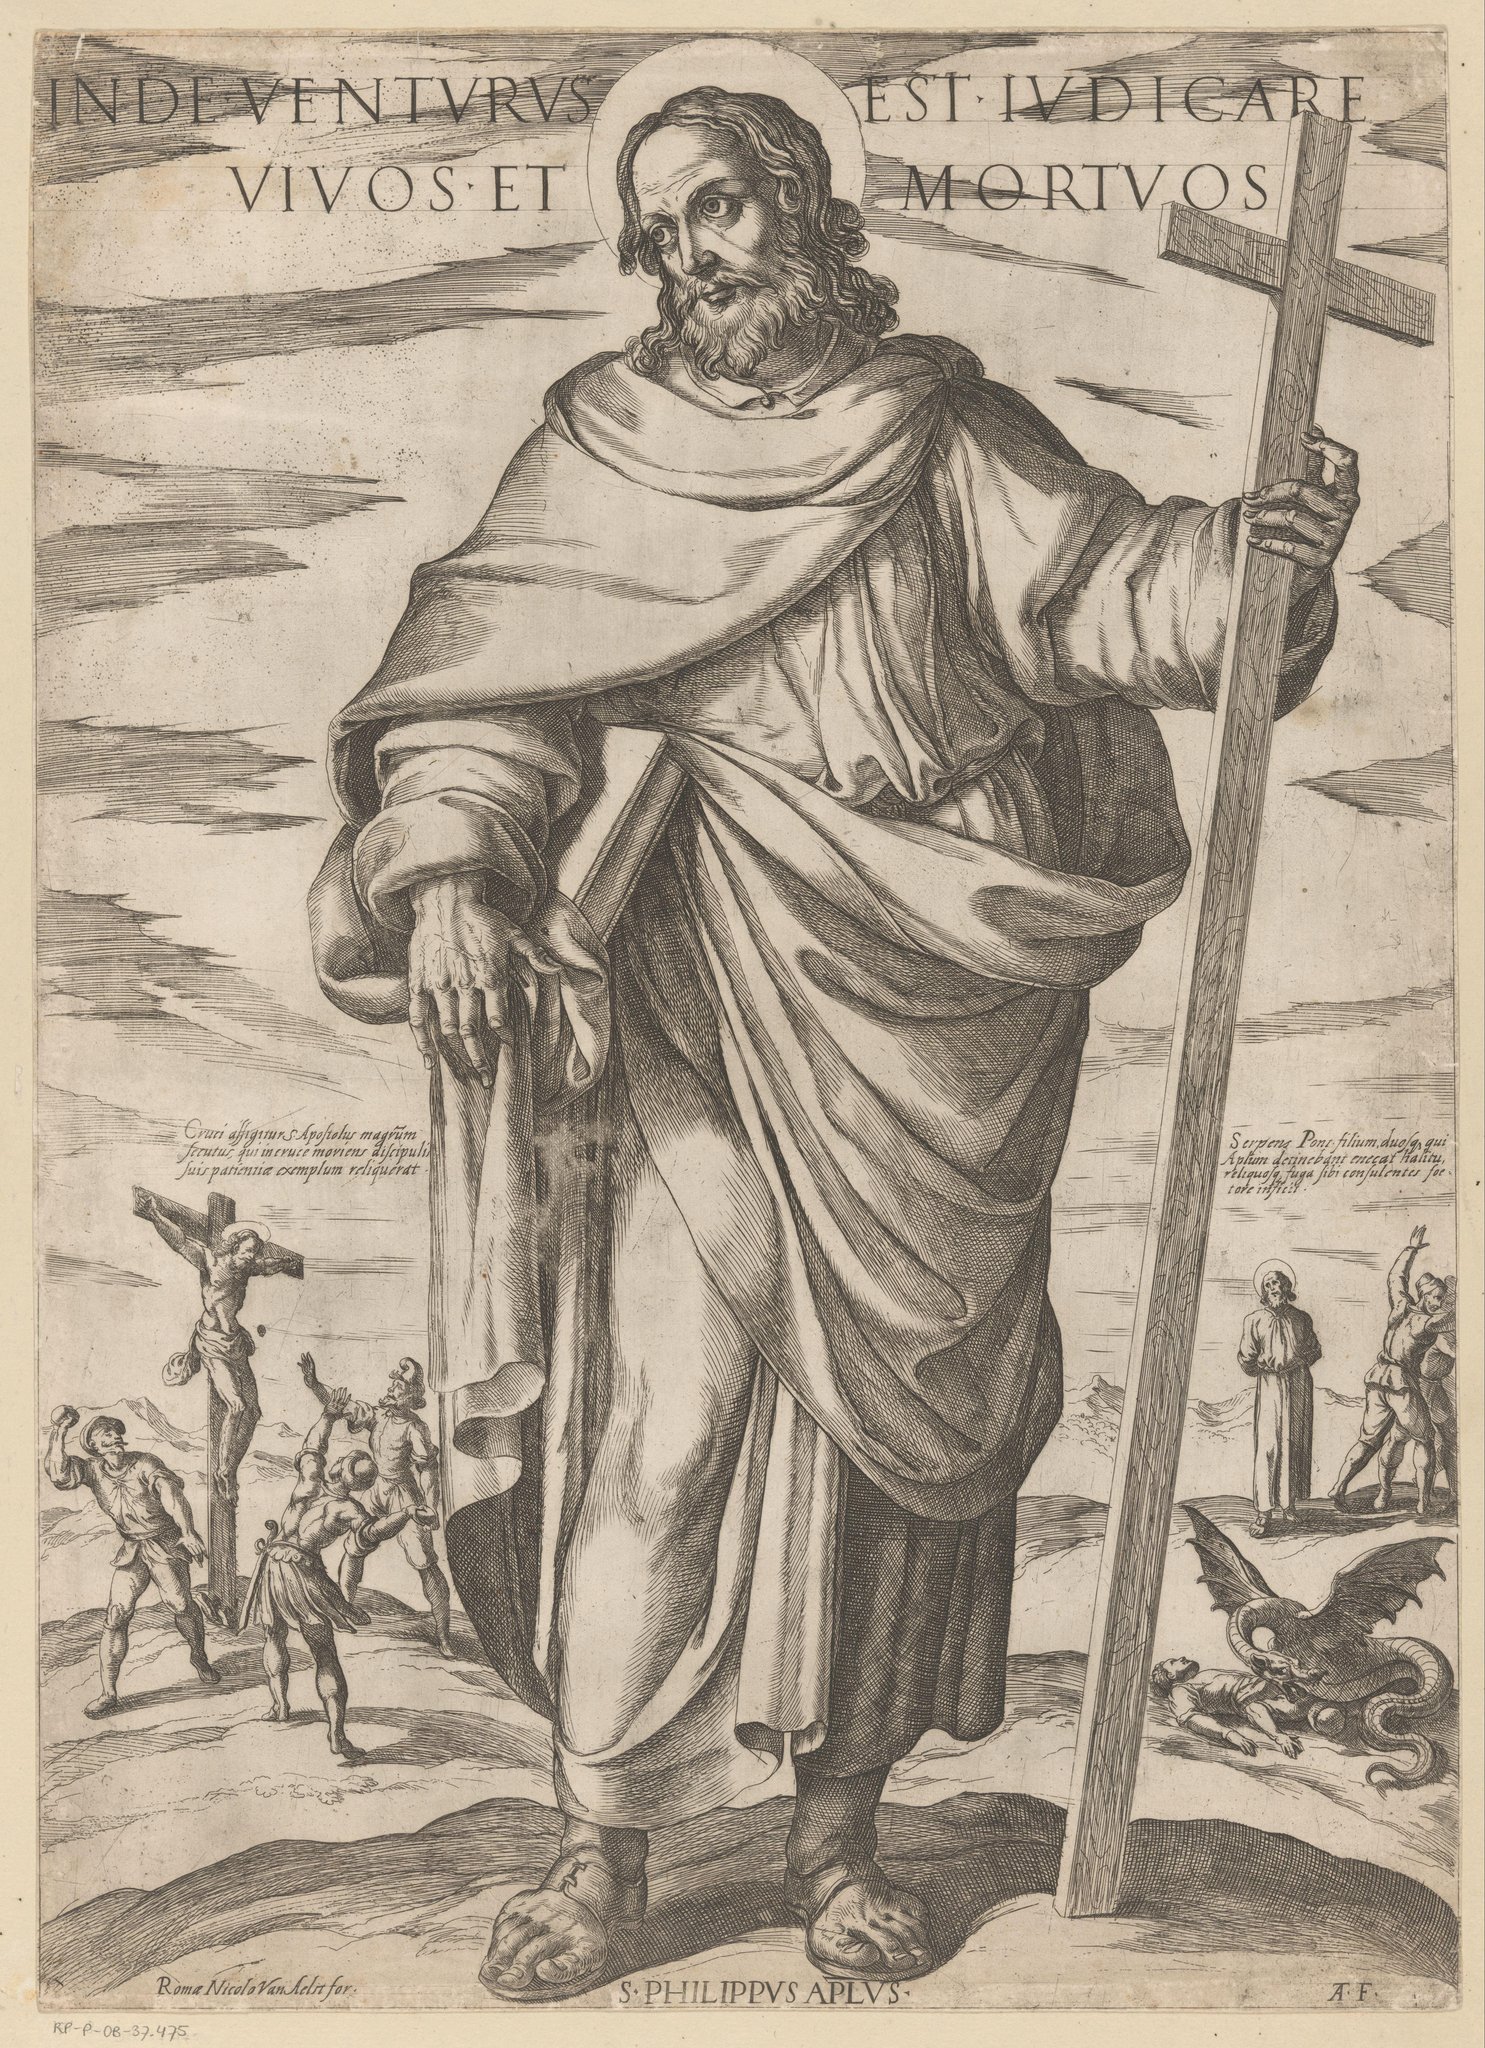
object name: print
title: Inde venturus est iudicare vivos et mortuos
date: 1565-1630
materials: paper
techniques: etching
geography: italy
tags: the apostle philip; possible attributes: book, cross, dish with snake, lance, scroll, stone, sword, while hanging on the cross philip is stoned, the dragon kills the son of the priest and two tribunes; bystanders get ill of the fumes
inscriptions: collector's mark: Lugt 240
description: De heilige Filippus met kruis en boek. Op de achtergrond links wordt Filippus gekruisigd en gestenigd. Op de achtergrond rechts een draak die een tegenstander van Filippus doodt.